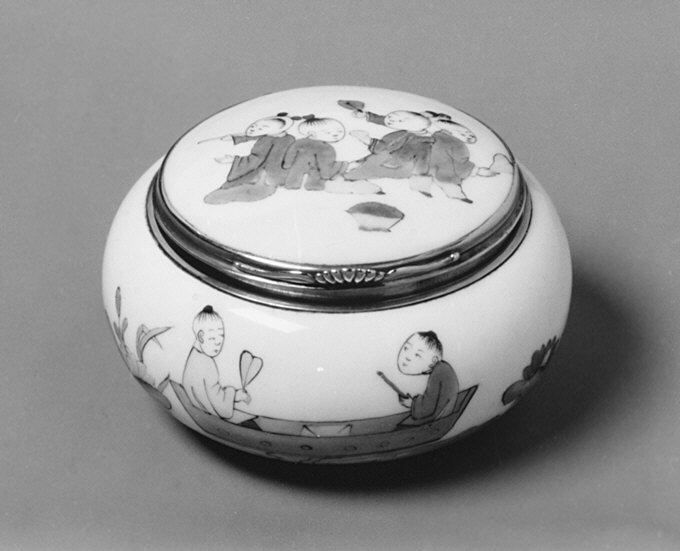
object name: snuffbox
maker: meissen manufactory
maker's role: manufactory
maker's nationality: german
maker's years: 1710-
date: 1730-1735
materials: gold, hard paste porcelain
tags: boys,rowing,boats